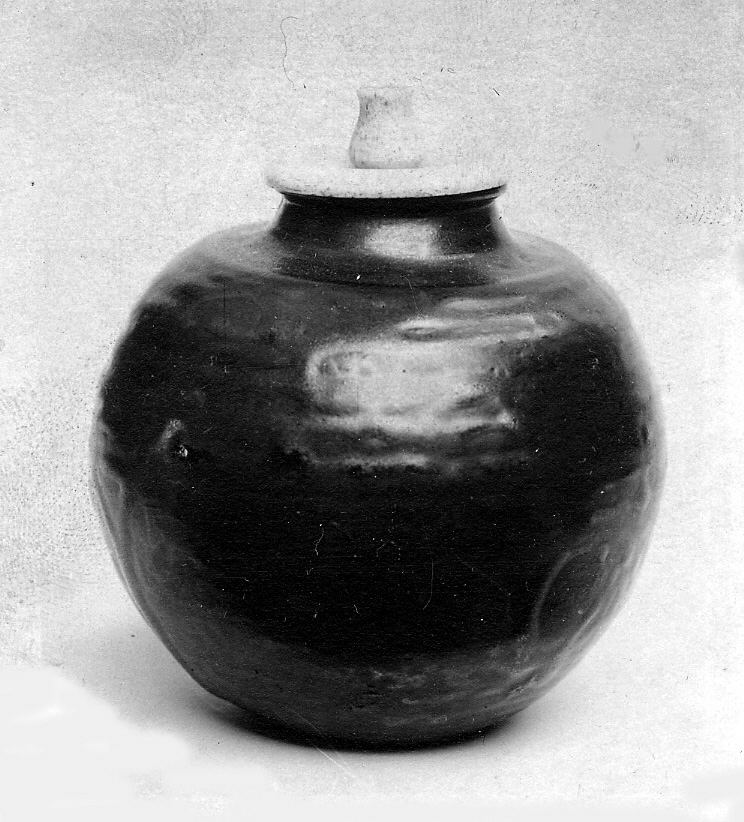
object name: tea caddy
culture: japanese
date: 1701-1800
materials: clay, glaze, ivory